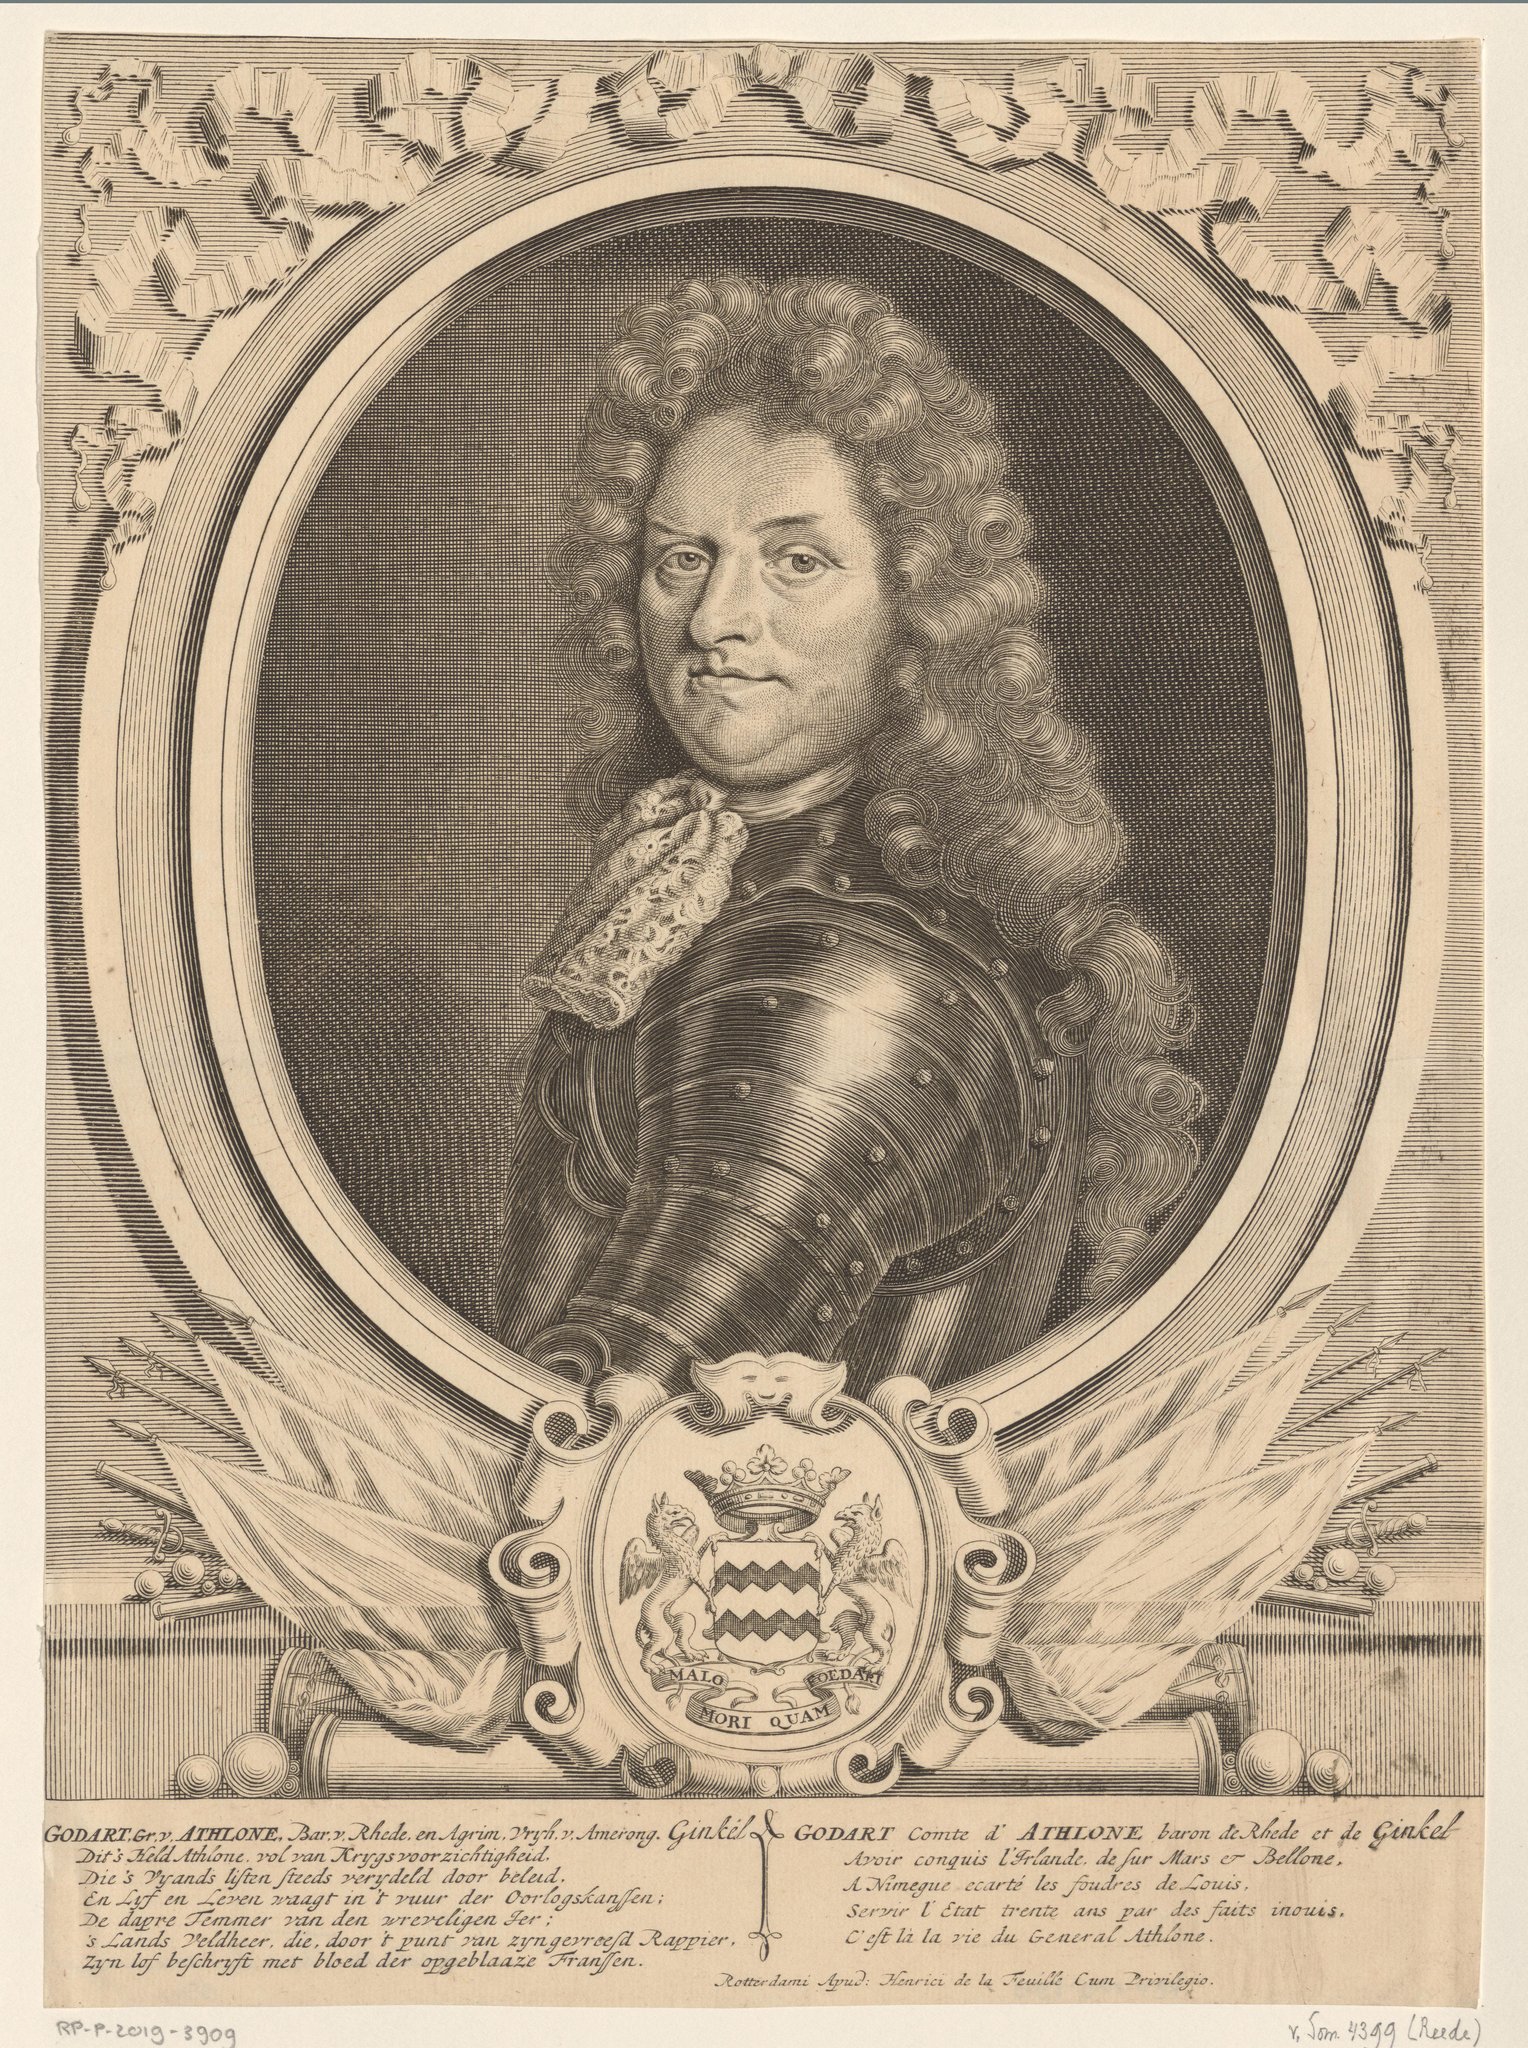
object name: print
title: Portret van Godard, baron van Reede-Ginckel, graaf van Athlone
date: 1700-1749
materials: paper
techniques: engraving, etching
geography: rotterdam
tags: utrecht, godard baron van reede-ginckel (graaf van athlone), armour, historical persons, armorial bearing, heraldry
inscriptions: collector's mark: Lugt 2228